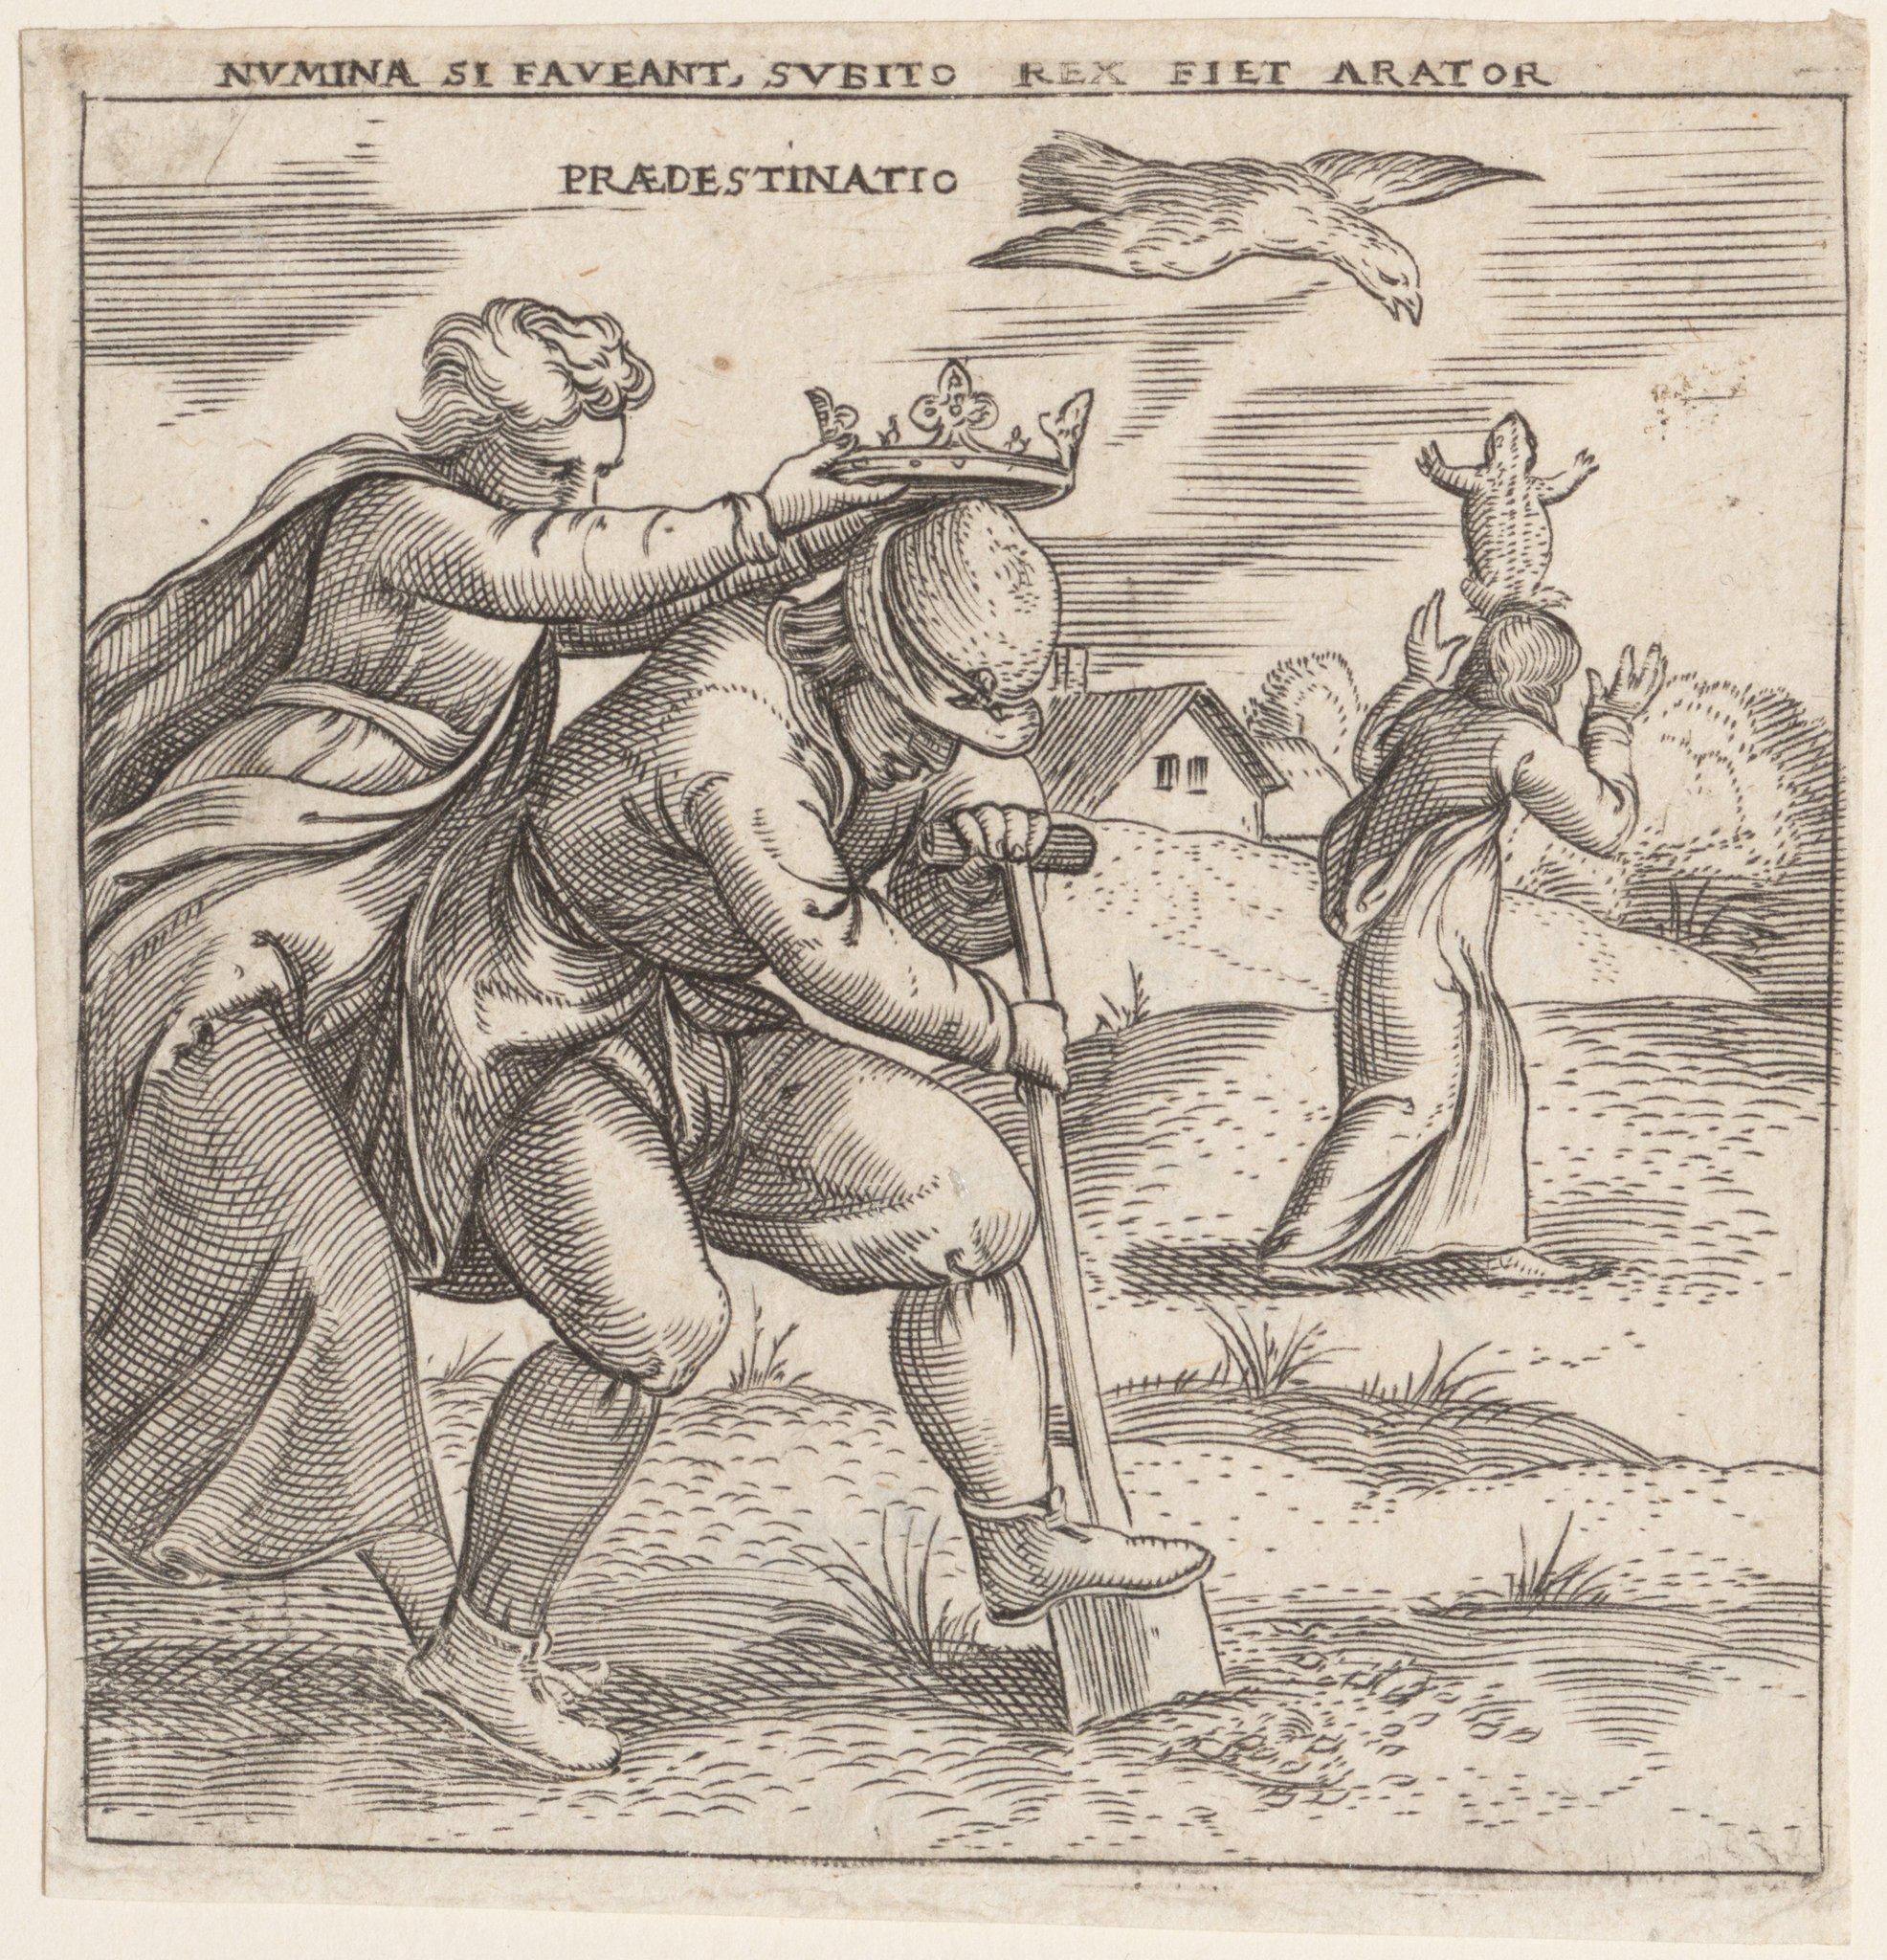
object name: print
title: Predestination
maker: enea vico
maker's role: artist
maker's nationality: italian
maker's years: 1523-1567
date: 1545-1550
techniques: engraving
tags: eagles,men,women